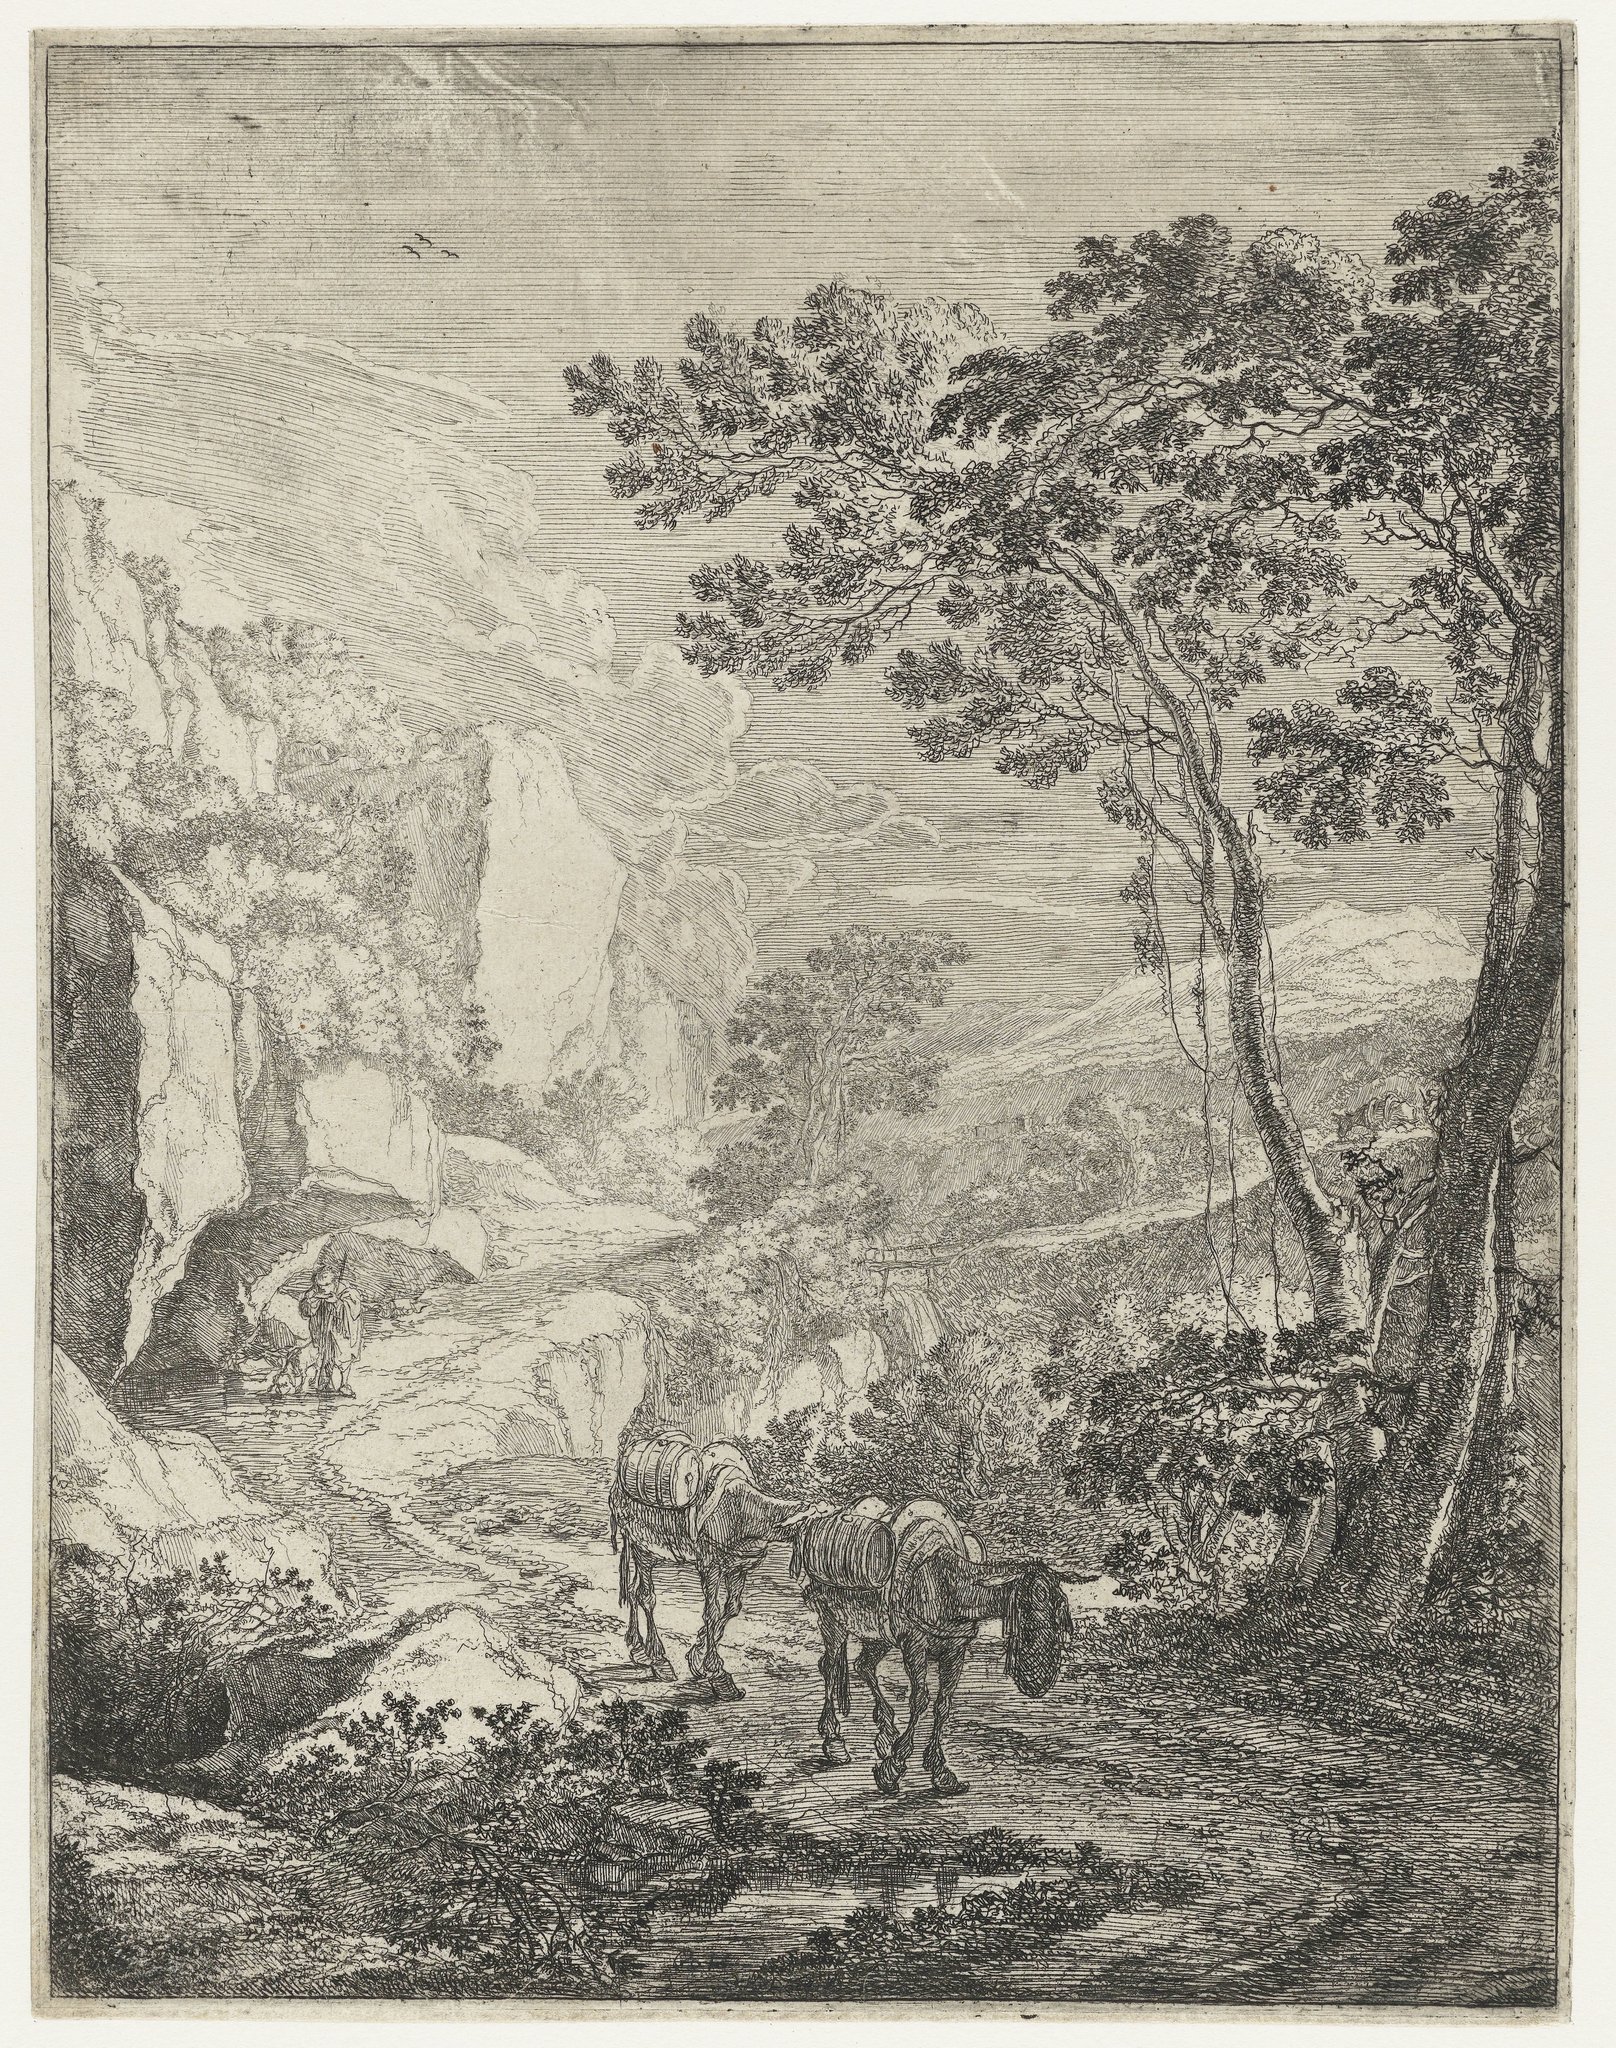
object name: print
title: Landschap met twee muilezels voor de Rocca Aquatico bij Ancona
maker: jan both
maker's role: draughtsman, painter, print maker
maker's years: 1618-1652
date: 1644-1652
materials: paper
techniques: etching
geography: utrecht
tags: mule, rocks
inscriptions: inscription: ‘bott’, collector's mark: Lugt 2228a